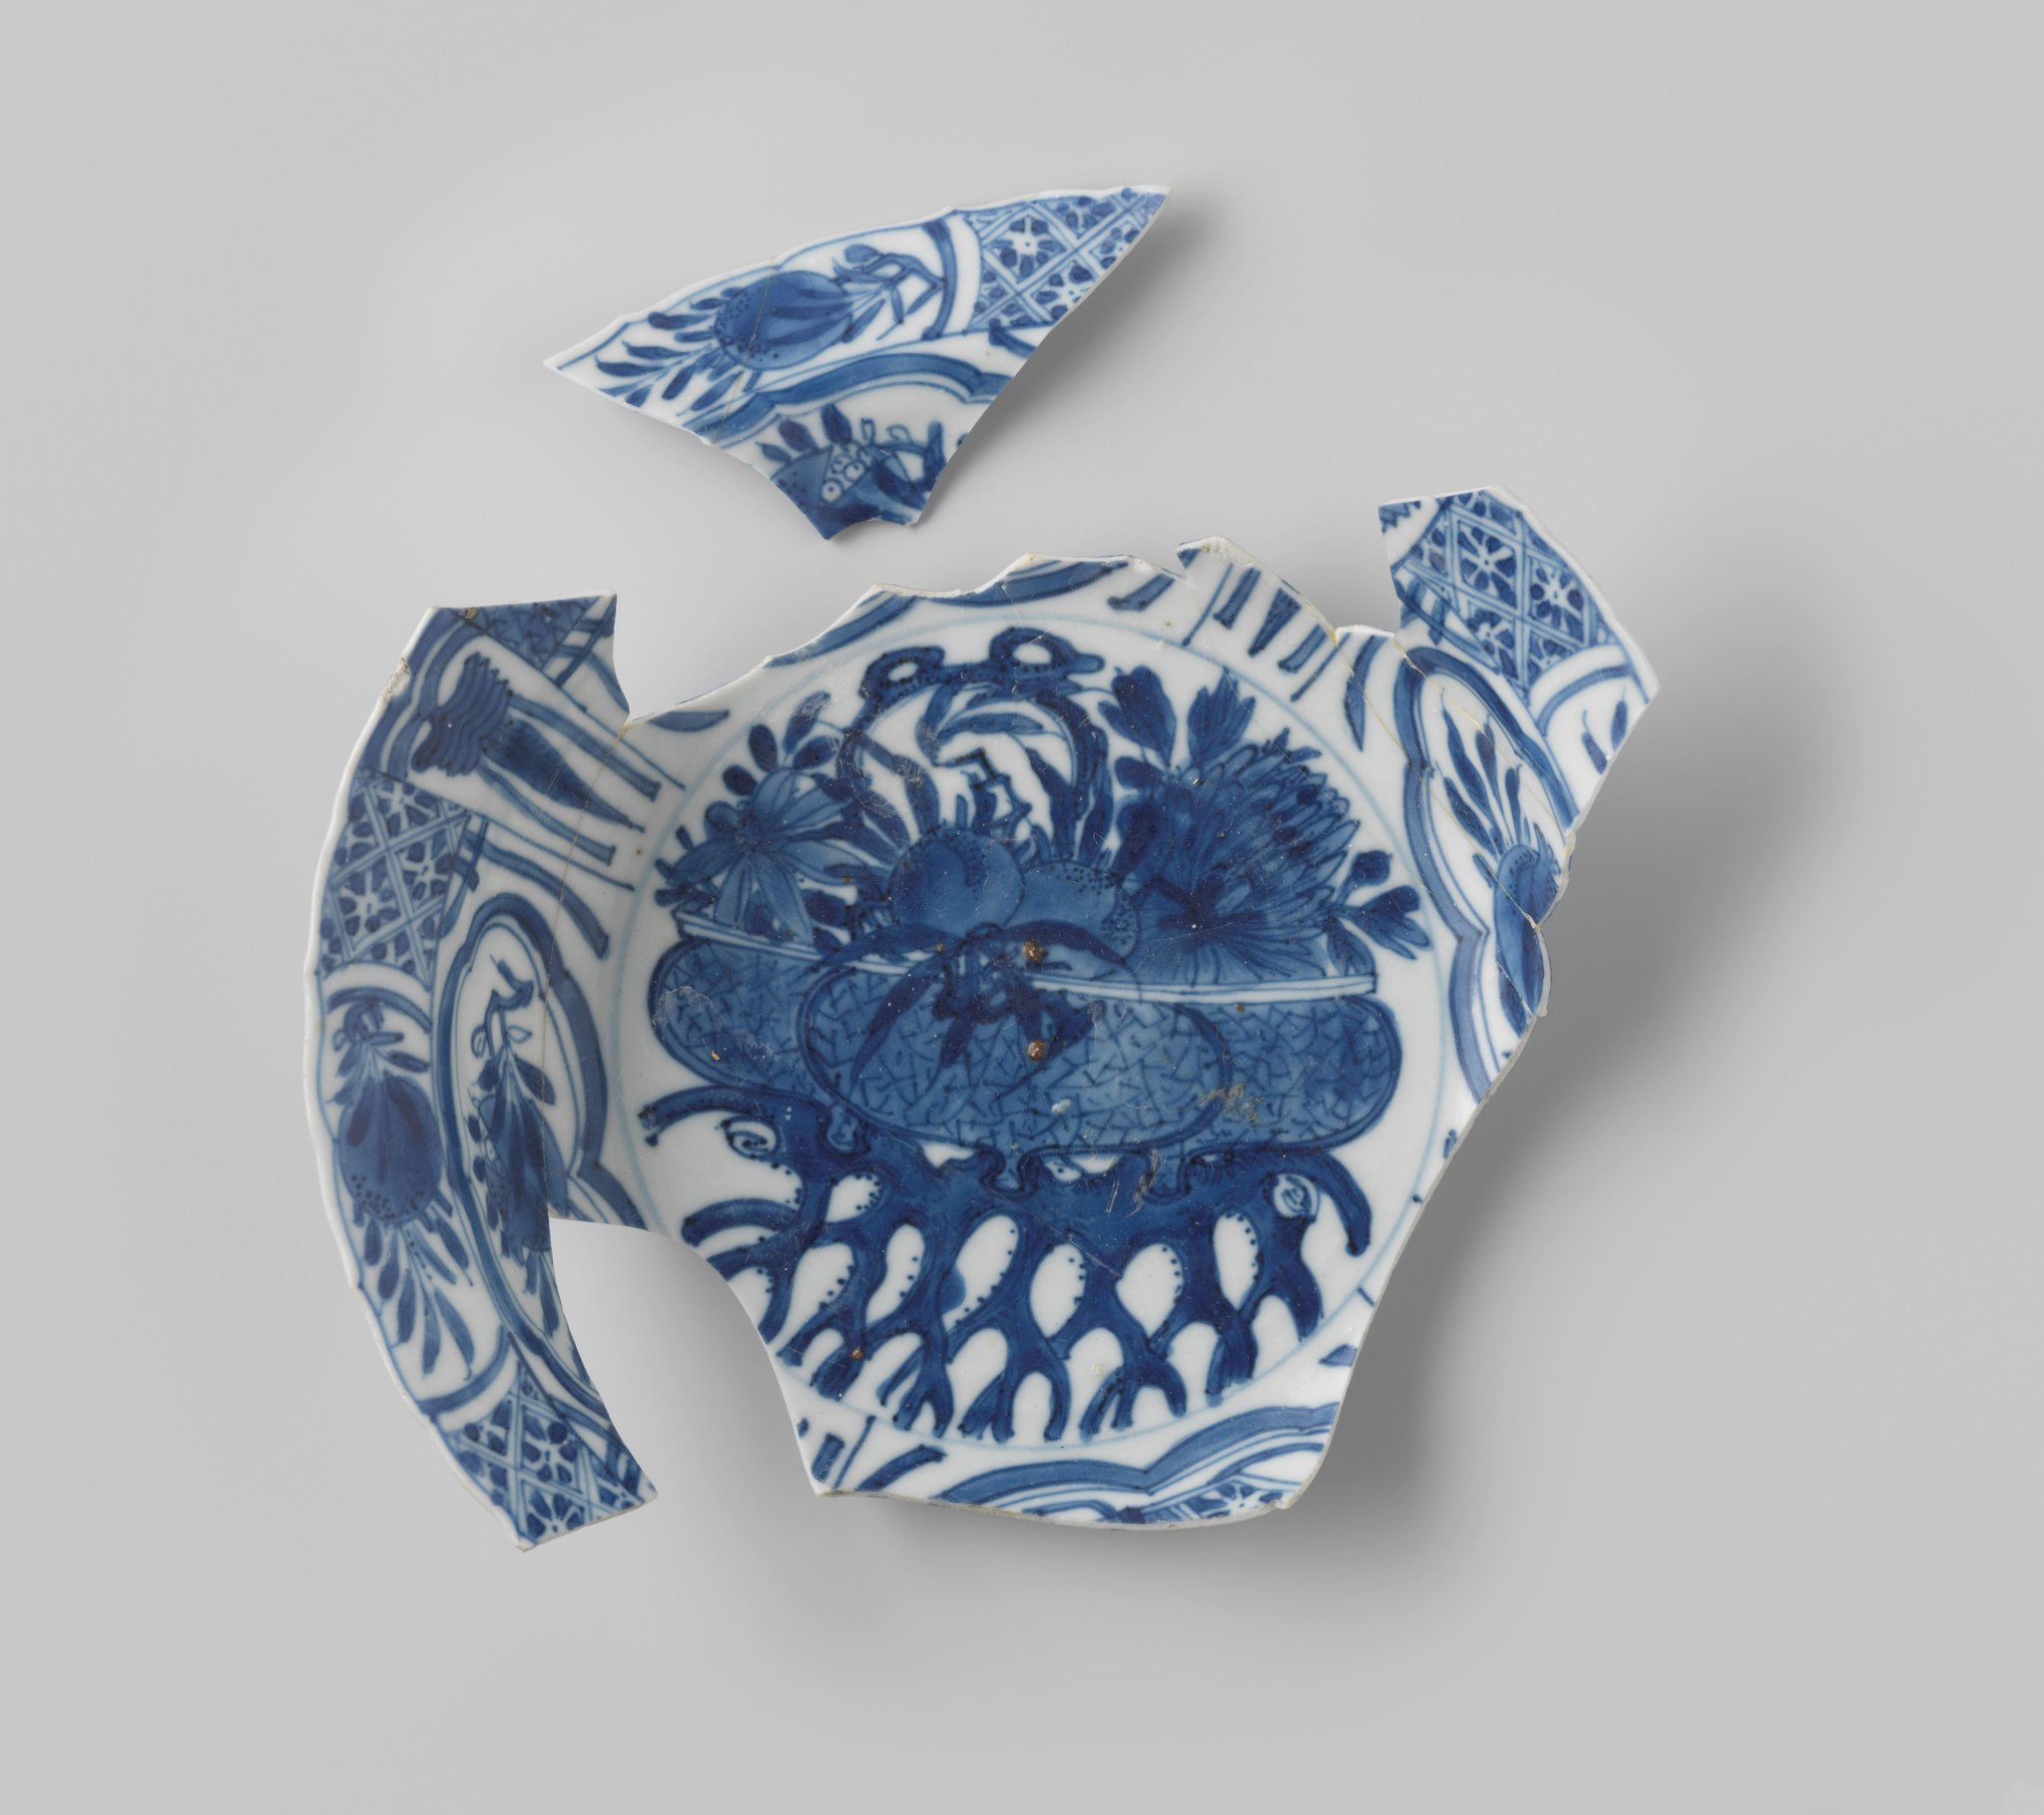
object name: plate dish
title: Diep bord uit V.O.C.-schip de 'Witte Leeuw'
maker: Anonymous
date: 1613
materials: bone china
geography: jingdezhen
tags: verenigde oostindische compagnie, sint-helena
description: A saucer without a flattened rim. A central decoration of a flower stand with fruits and flowers on a frame made of roots. Panels decorated with fruits and symbols.